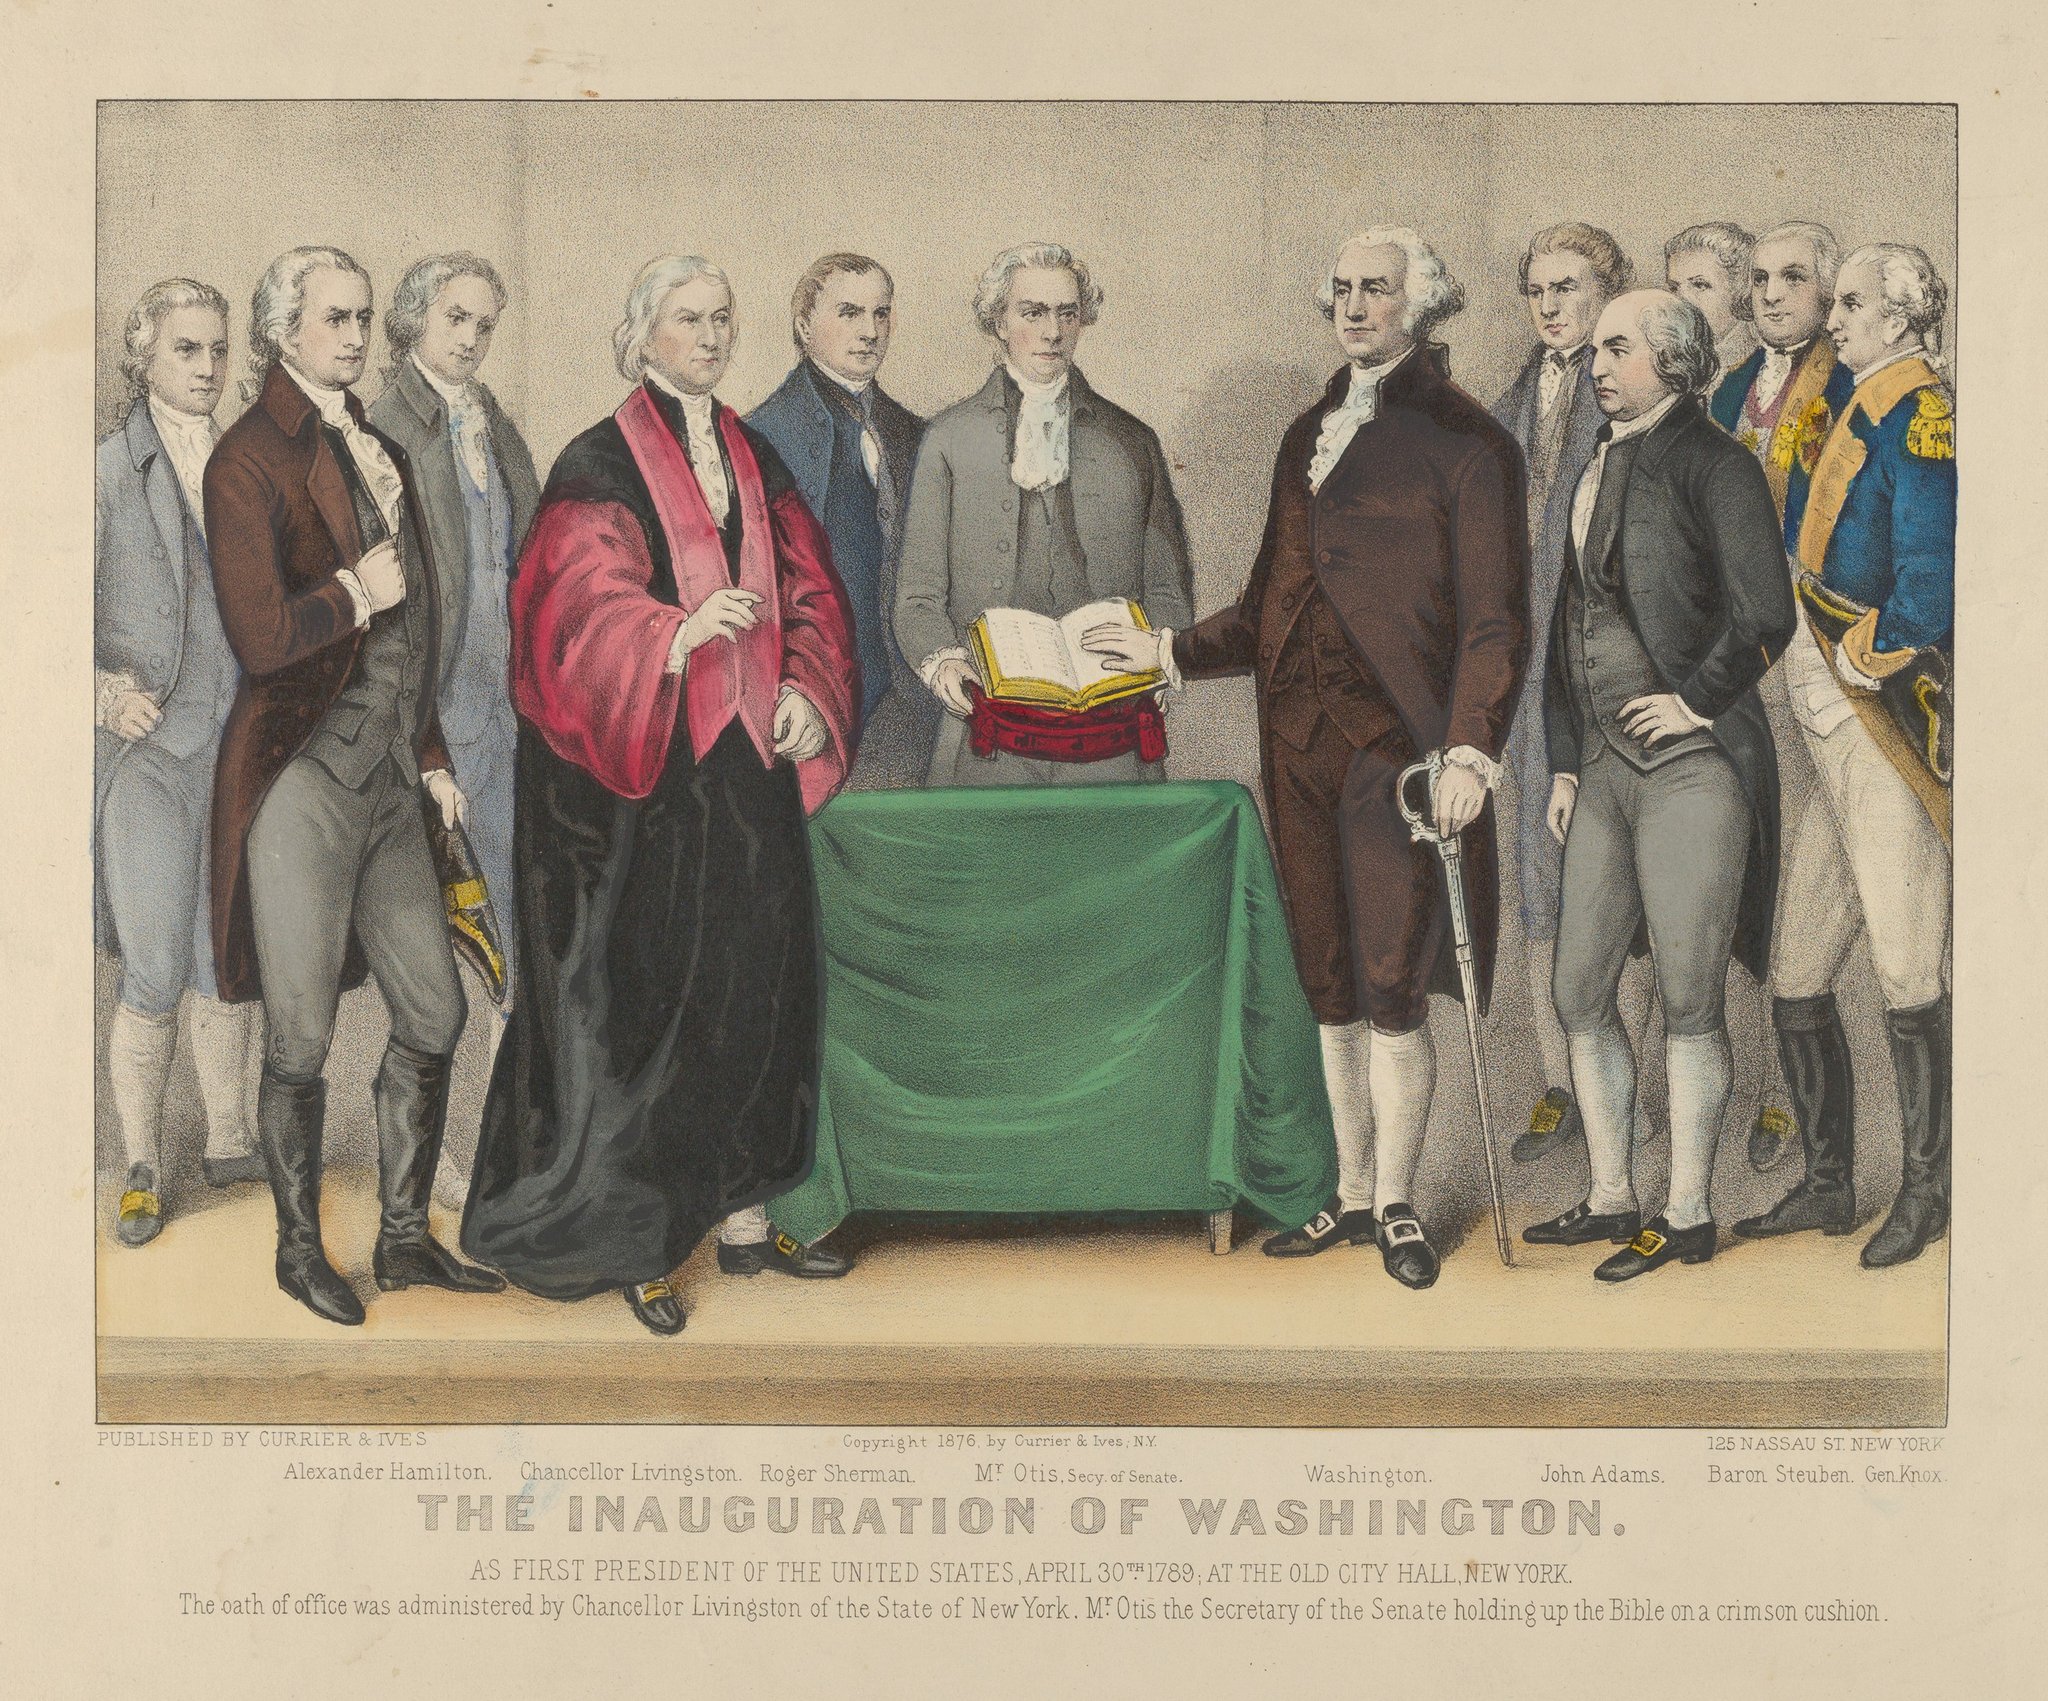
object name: print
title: The Inauguration of Washington as First President of the United States, April 30th 1789 – At the Old City Hall, New York – The oath of office was administered by Chancellor Livingston of the States of New York – Mr. Otis the Secretary of the Senate holding up the Bible on a crimson cushion.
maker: currier & ives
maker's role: publisher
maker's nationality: american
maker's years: 1857-1907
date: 1876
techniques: hand coloring, lithograph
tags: swords,george washington,men